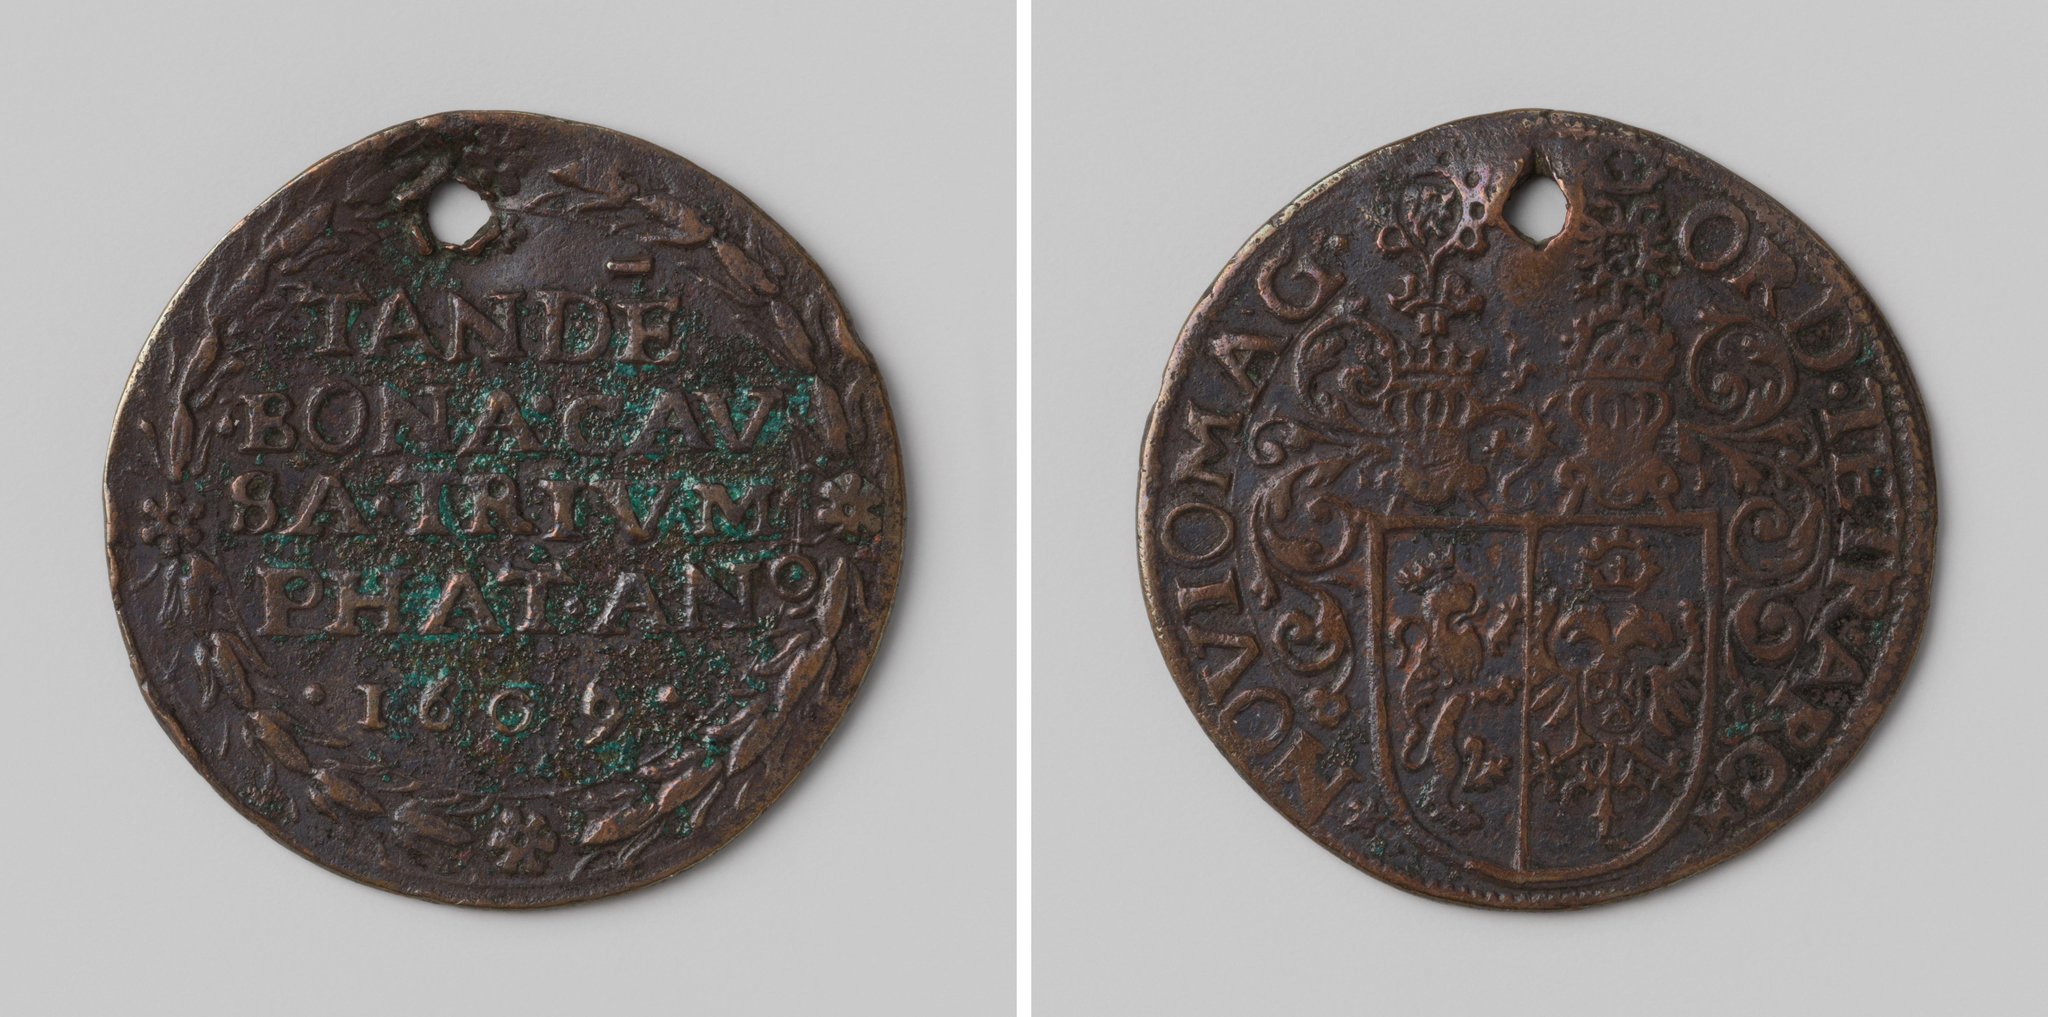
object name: jeton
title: Sluiting van het Twaalfjarig Bestand tussen de Republiek en Spanje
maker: Anonymous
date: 1609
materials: copper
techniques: striking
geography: netherlands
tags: nijmegen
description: Koperen penning met gat erin. Voorzijde: opschrift binnen krans van olijftakken. Keerzijde: wapenschild onder twee gekroonde helmen binnen omschrift.